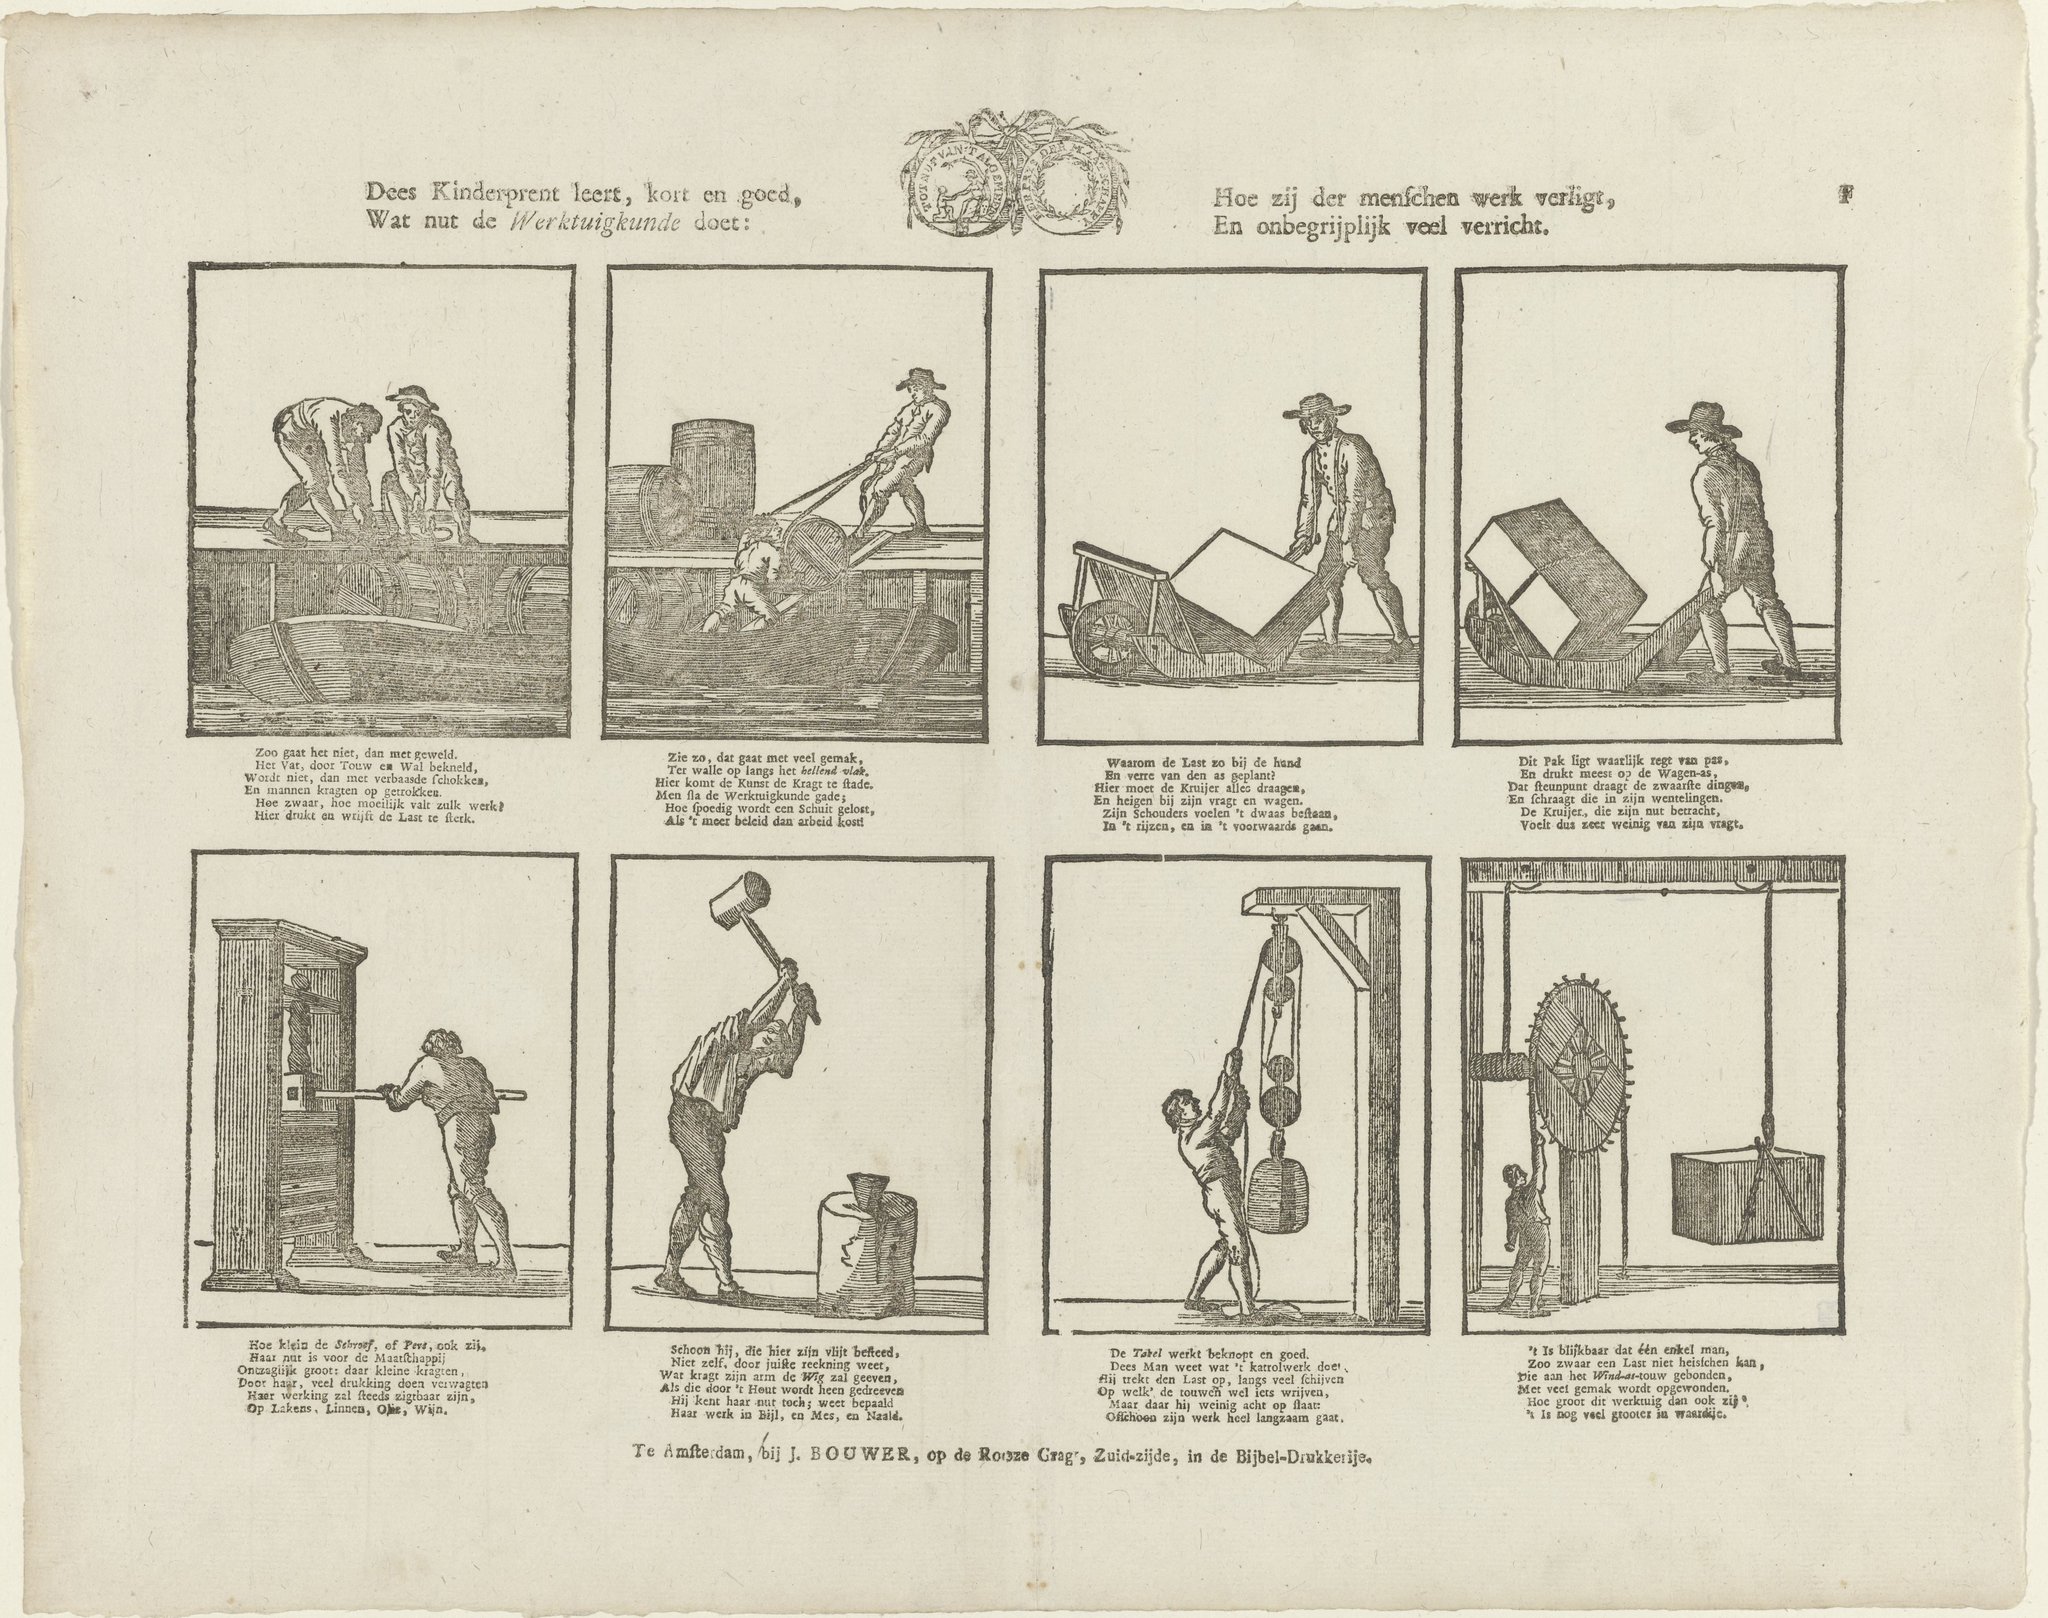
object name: print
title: Dees kinderprent leert, kort en goed, / Wat nut de werktuigkunde doet: / Hoe zij der menschen werk verligt, / En onbegrijplijk veel verricht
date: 1805-1808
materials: paper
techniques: letterpress printing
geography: amsterdam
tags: tools and machines ~ building, dynamics, kinetics, printing press, dock crane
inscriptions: collector's mark: Lugt 2760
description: Blad met 8 voorstellingen van mannen die werktuigen gebruiken, zoals een pers en een hijskraan. Midden boven het zegel van de Maatschappij tot Nut van 't Algemeen. Onder elke afbeelding een zesregelig vers. Genummerd rechtsboven: F.